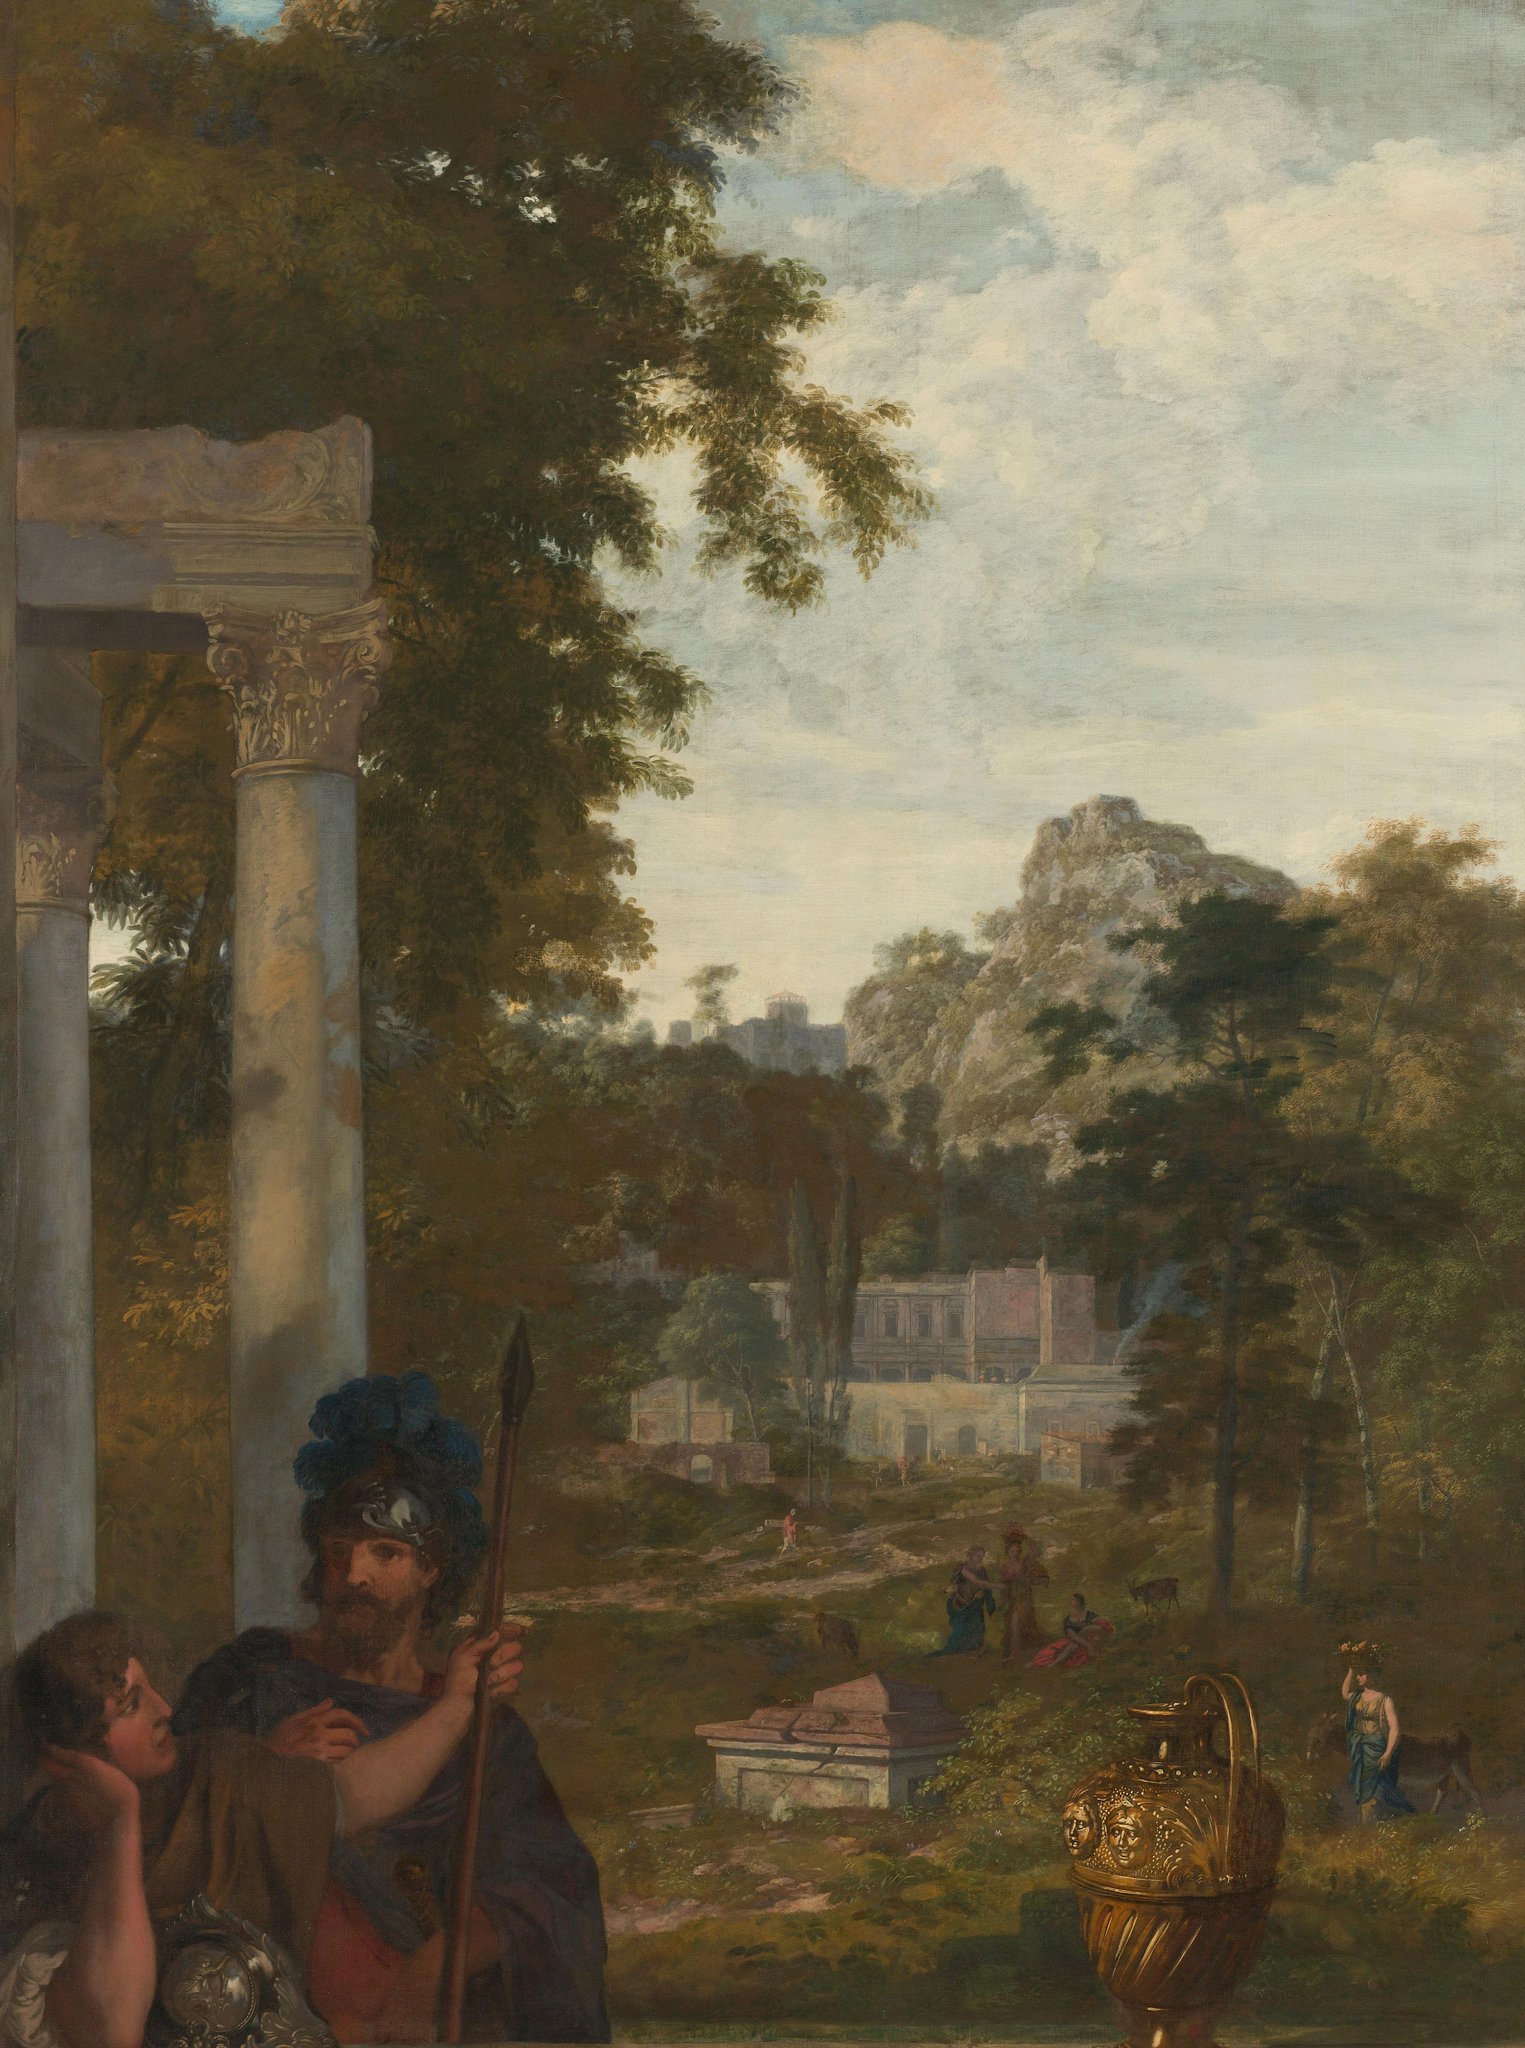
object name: painting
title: Italian Landscape with two Roman Soldiers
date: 1687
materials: canvas, oil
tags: landscape with ruins - ii - ideal landscapes, pastorals, arcadian scenes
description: Gerard Lairesse (1614 - 1711) and Johannes Glauber (1646 - c. 1726). Italian landscape with two Roman soldiers.